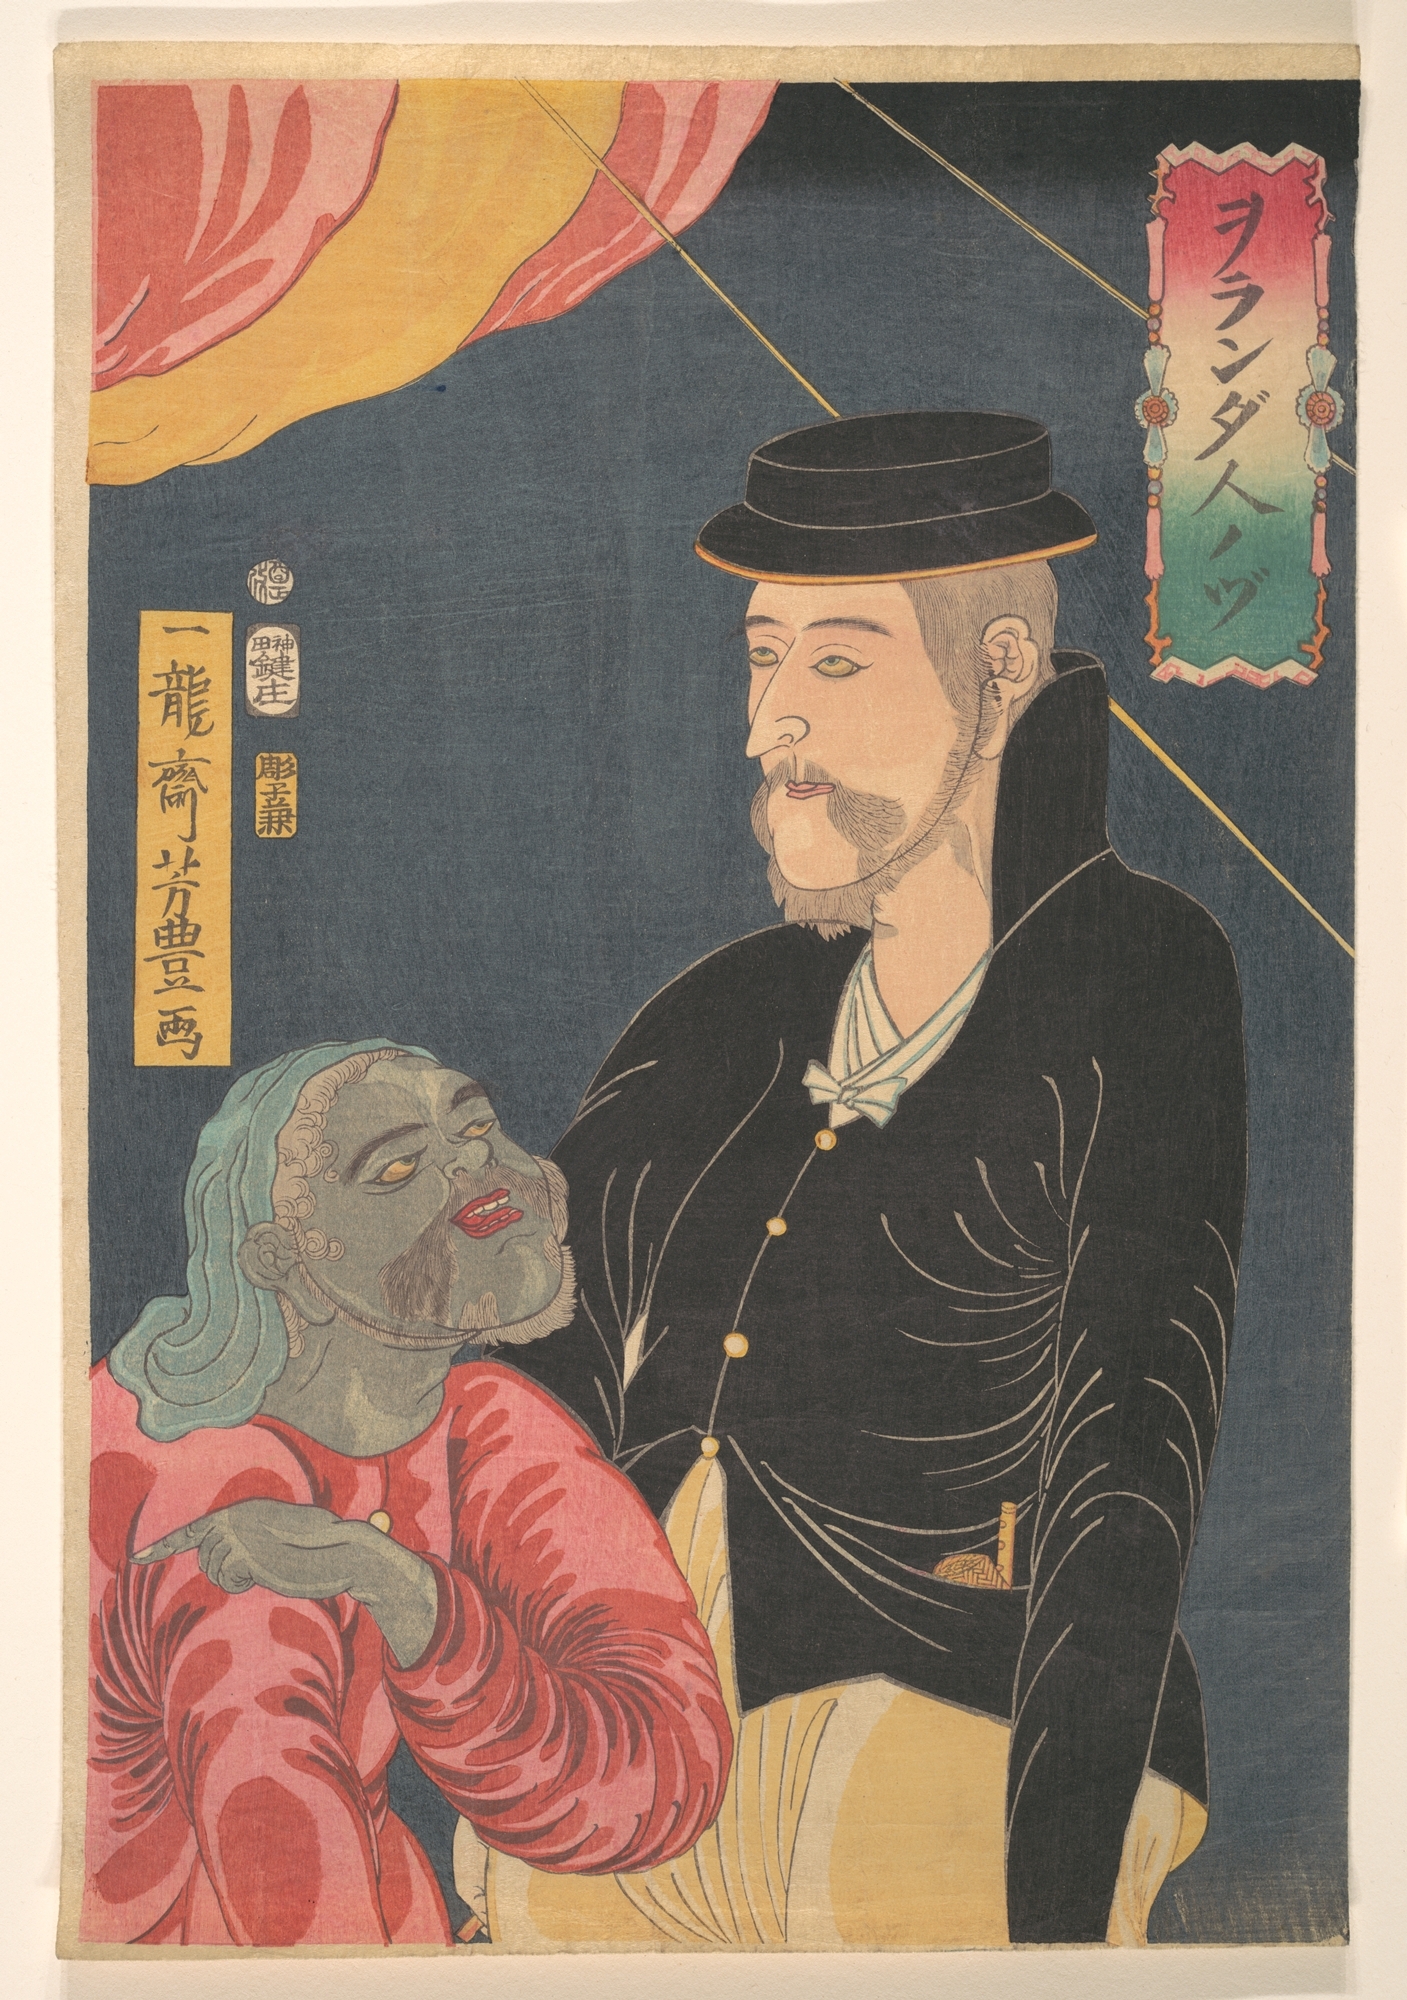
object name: print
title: Dutchman with Black Servant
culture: japanese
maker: ichiryūsai yoshitoyo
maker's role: artist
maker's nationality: japanese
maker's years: 1830-1866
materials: ink, paper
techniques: woodblock print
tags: men